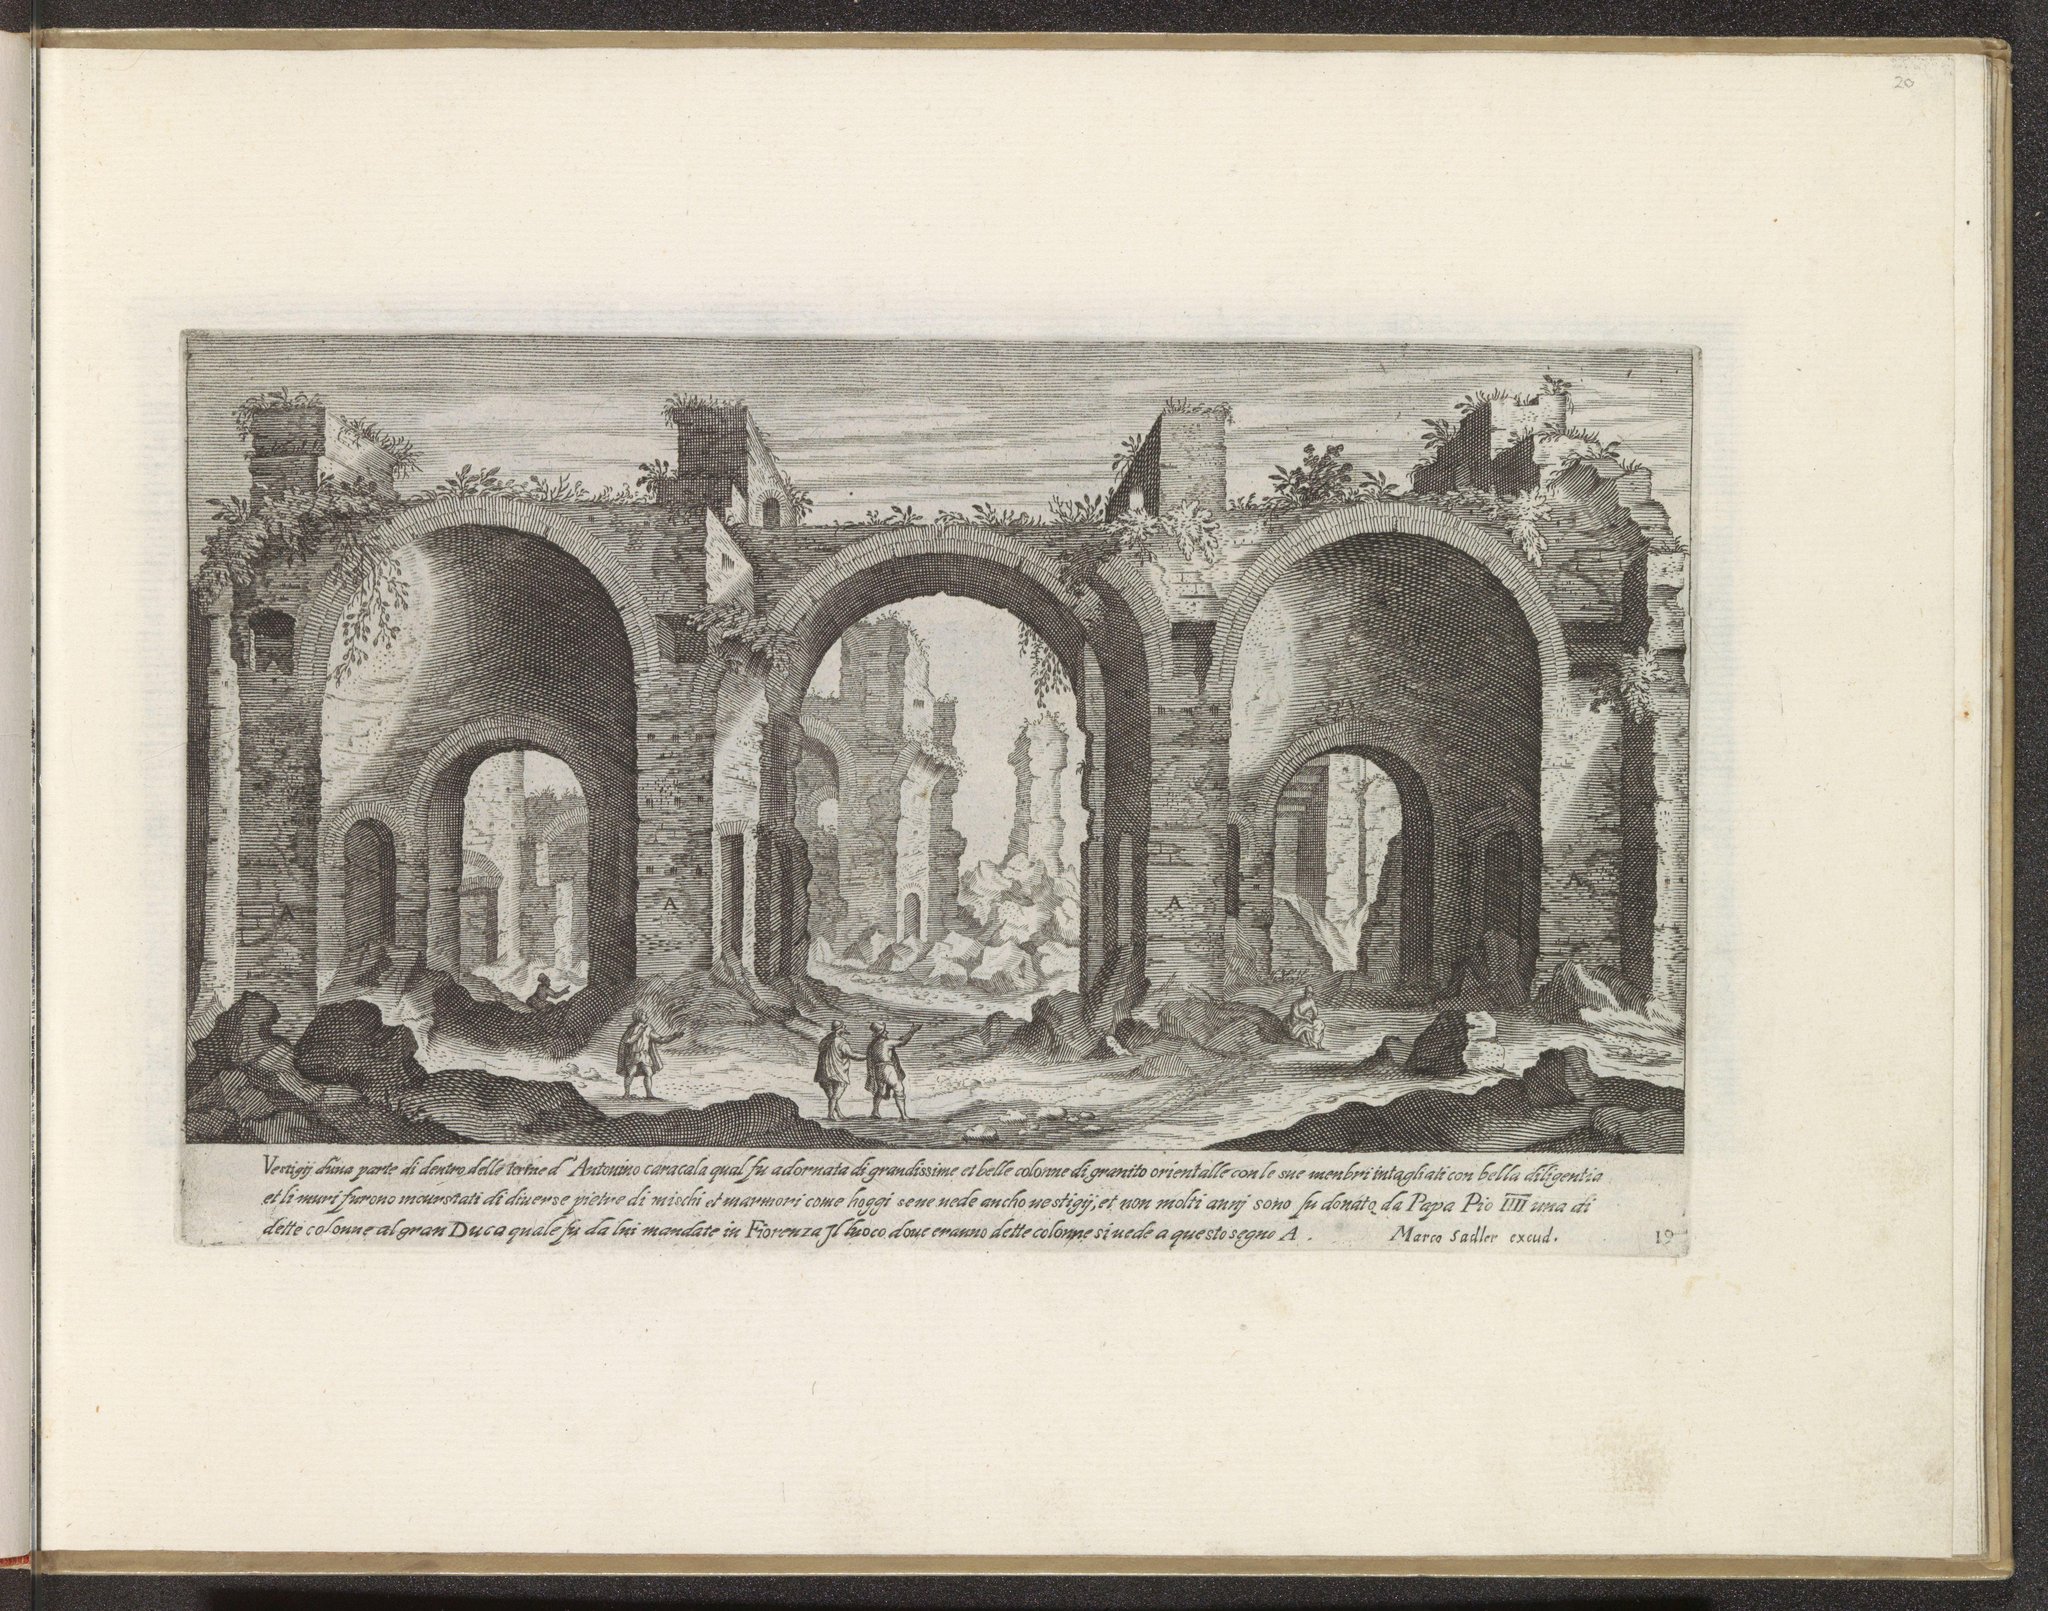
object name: album leaf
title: Thermen van Caracalla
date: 1606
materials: paper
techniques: engraving, etching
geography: prague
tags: rome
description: Ruïnes van de Thermen van Caracalla in Rome. Op de voorgrond aanschouwen drie mensen het gebouw. In de ondermarge drie regels tekst in het Italiaans. De prent maakt deel uit van een album.